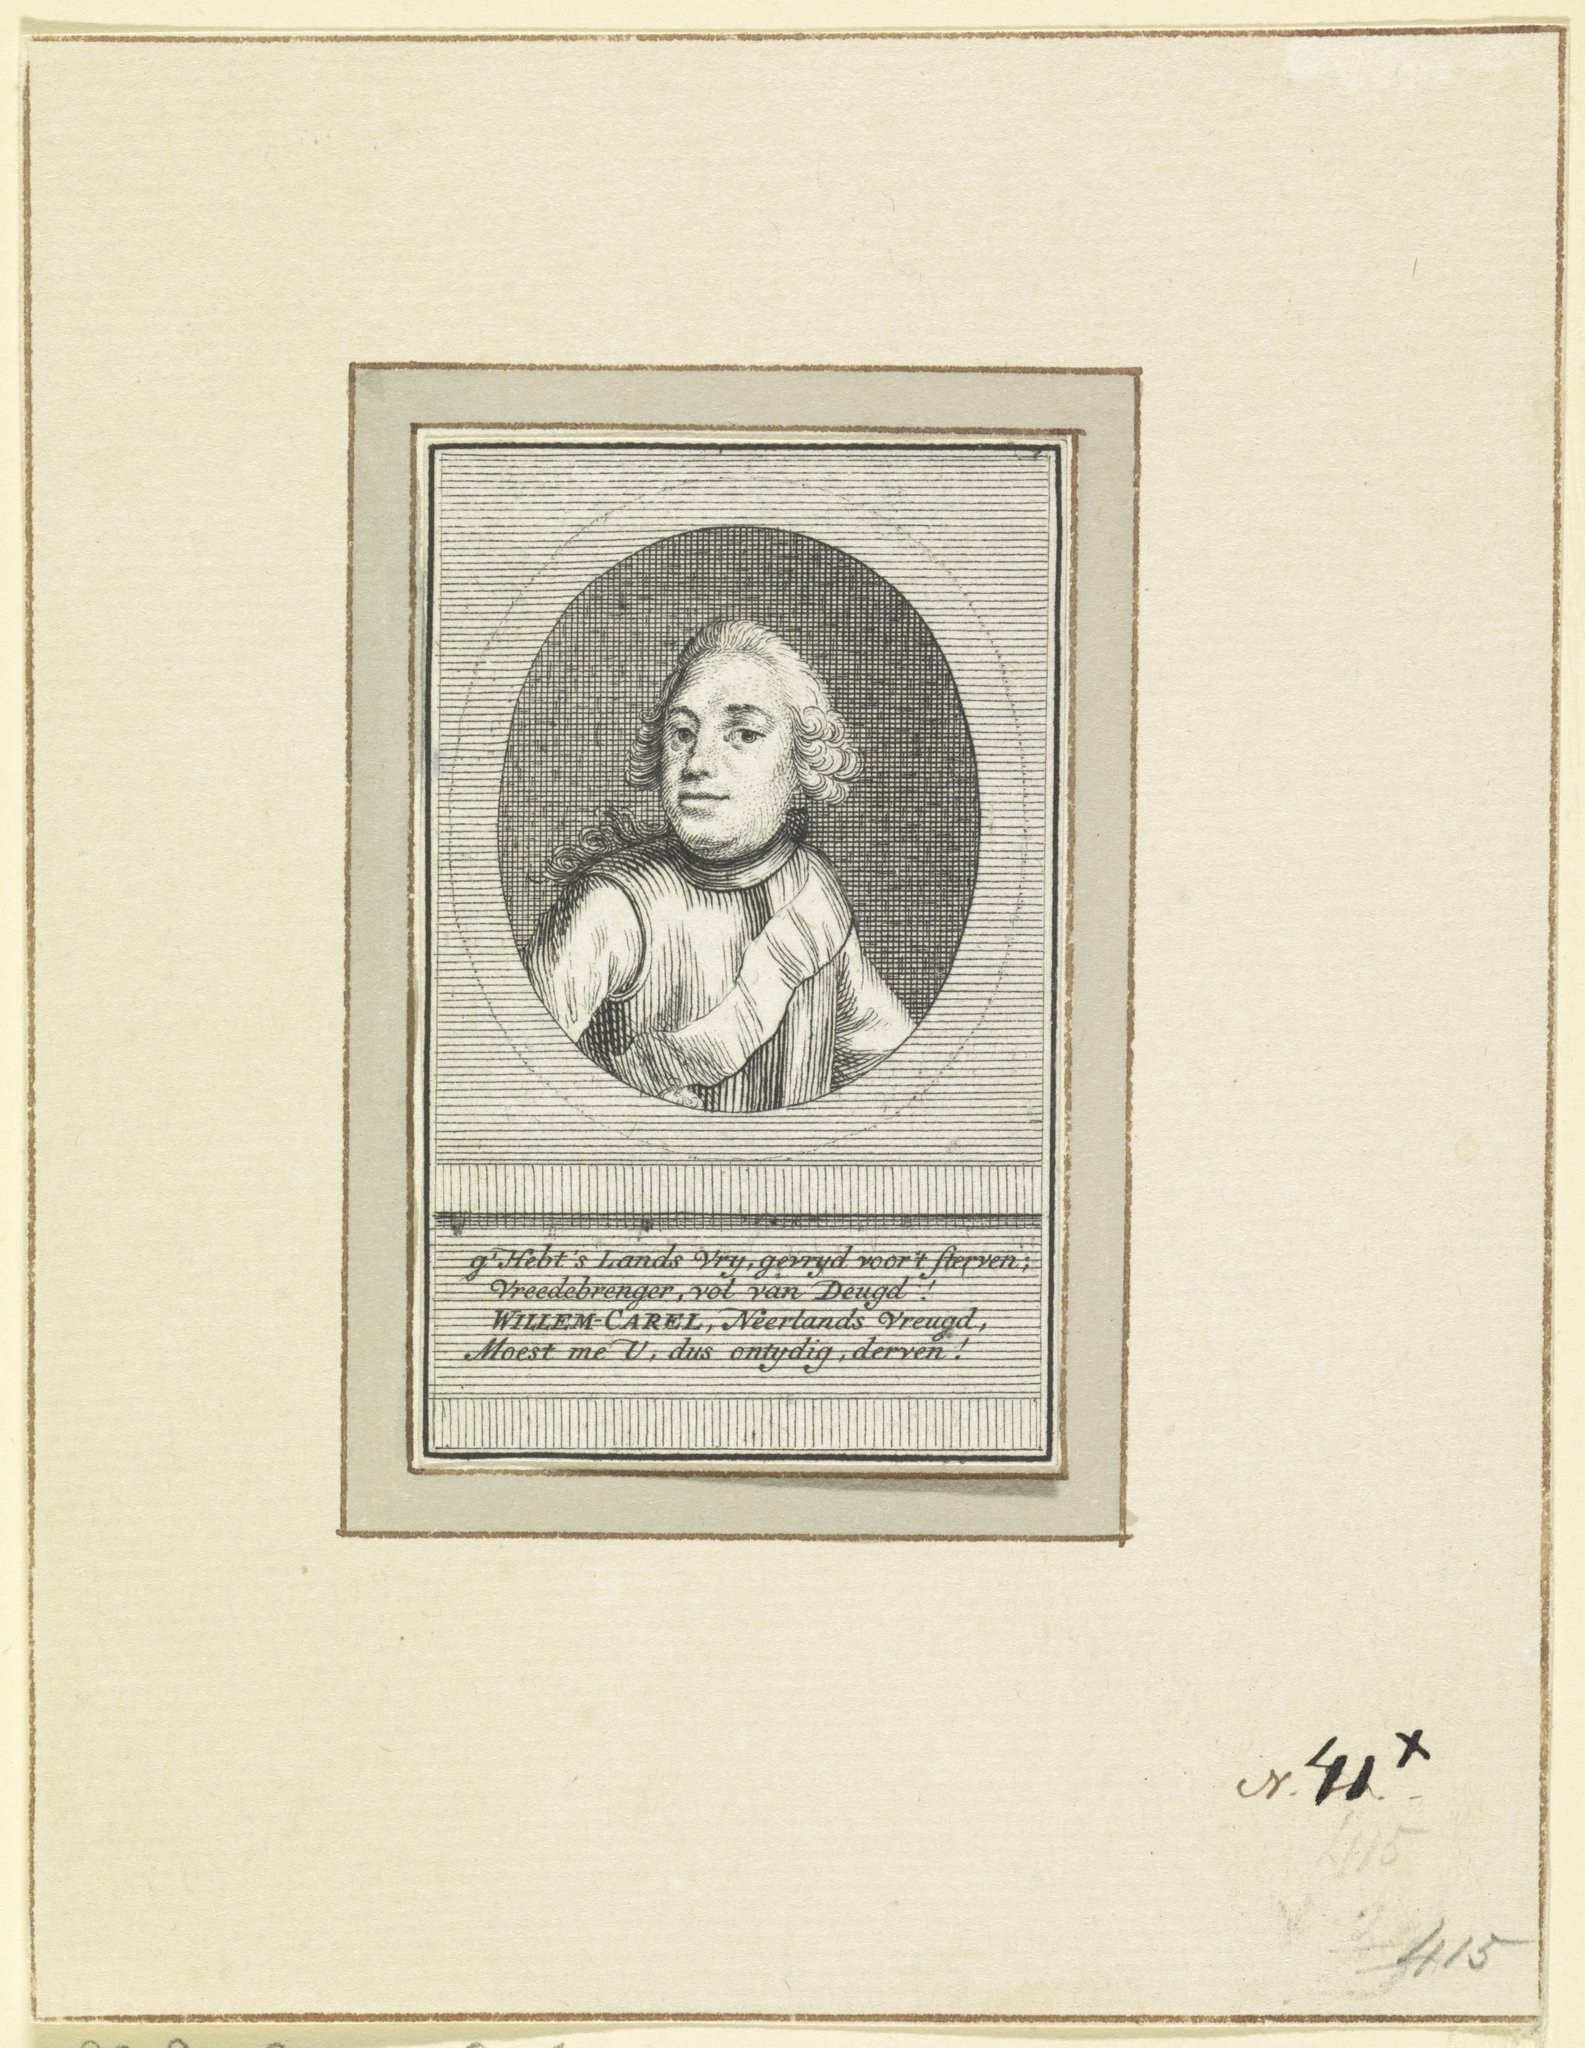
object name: print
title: Portret van Willem IV, prins van Oranje-Nassau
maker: Anonymous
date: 1751-1849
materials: paper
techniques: etching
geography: low countries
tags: the hague, willem iv (prins van oranje-nassau)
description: De hier vermelde titel verwijst naar de hoogst verkregen titel van de geportretteerde, niet per se naar de titel die de geportretteerde op deze voorstelling draagt.